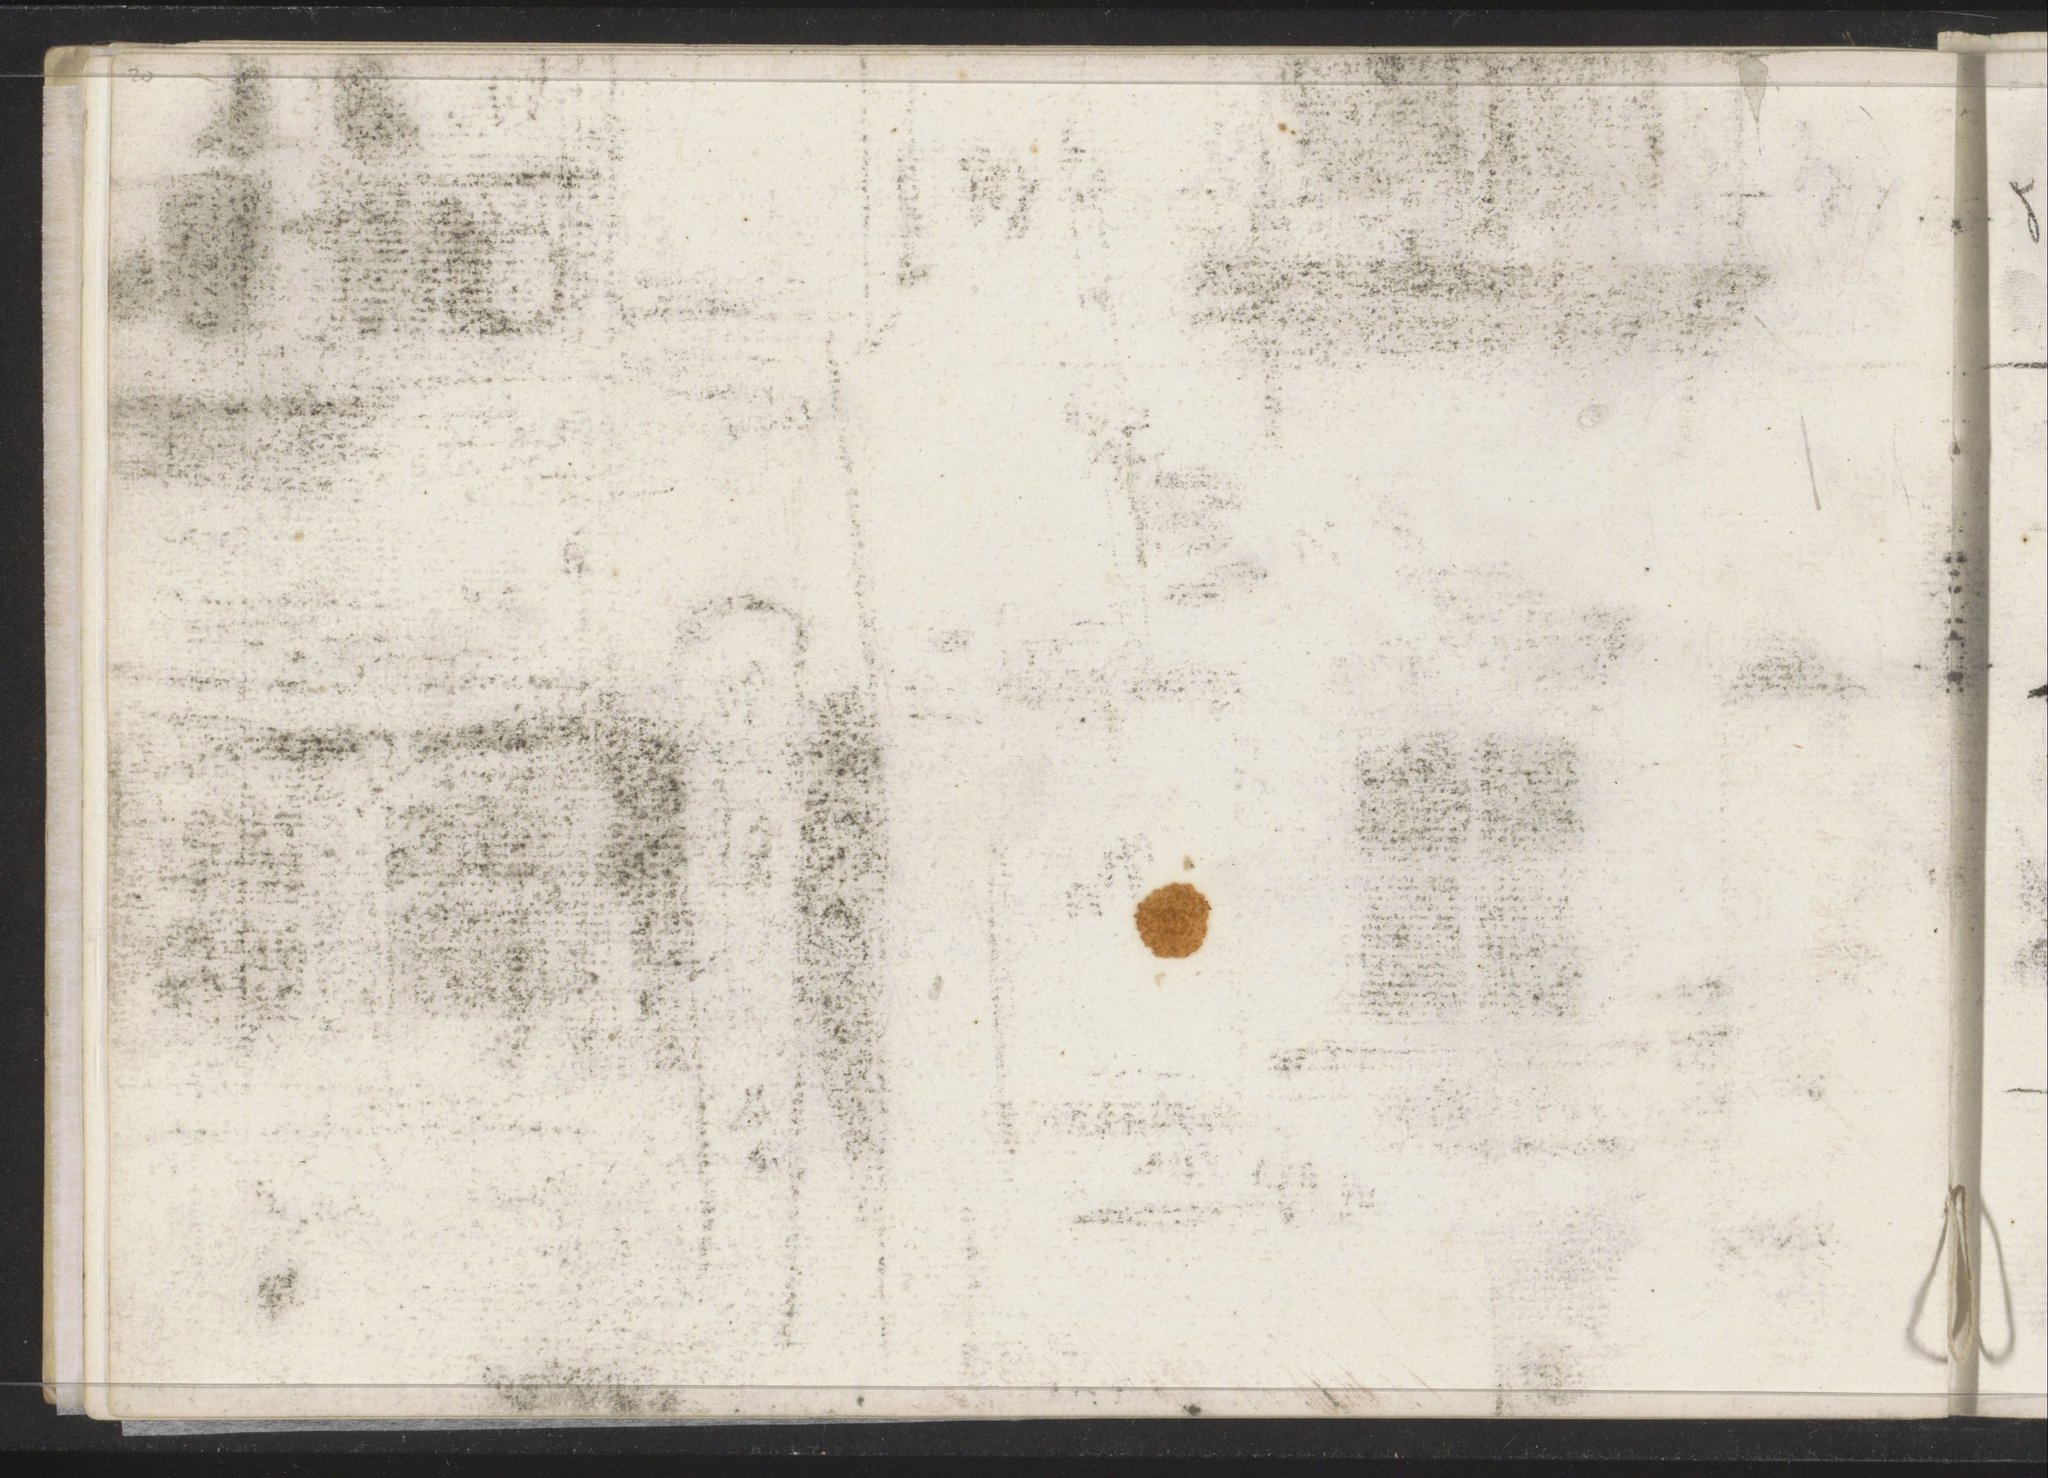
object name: sketchbook leaf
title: Abklatsch van de krijttekening op pagina 21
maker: willem witsen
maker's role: draughtsman, painter, print maker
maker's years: 1860-1923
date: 1897-1899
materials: paper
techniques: printmaking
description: Pagina 20 uit een schetsboek met 17 bladen.